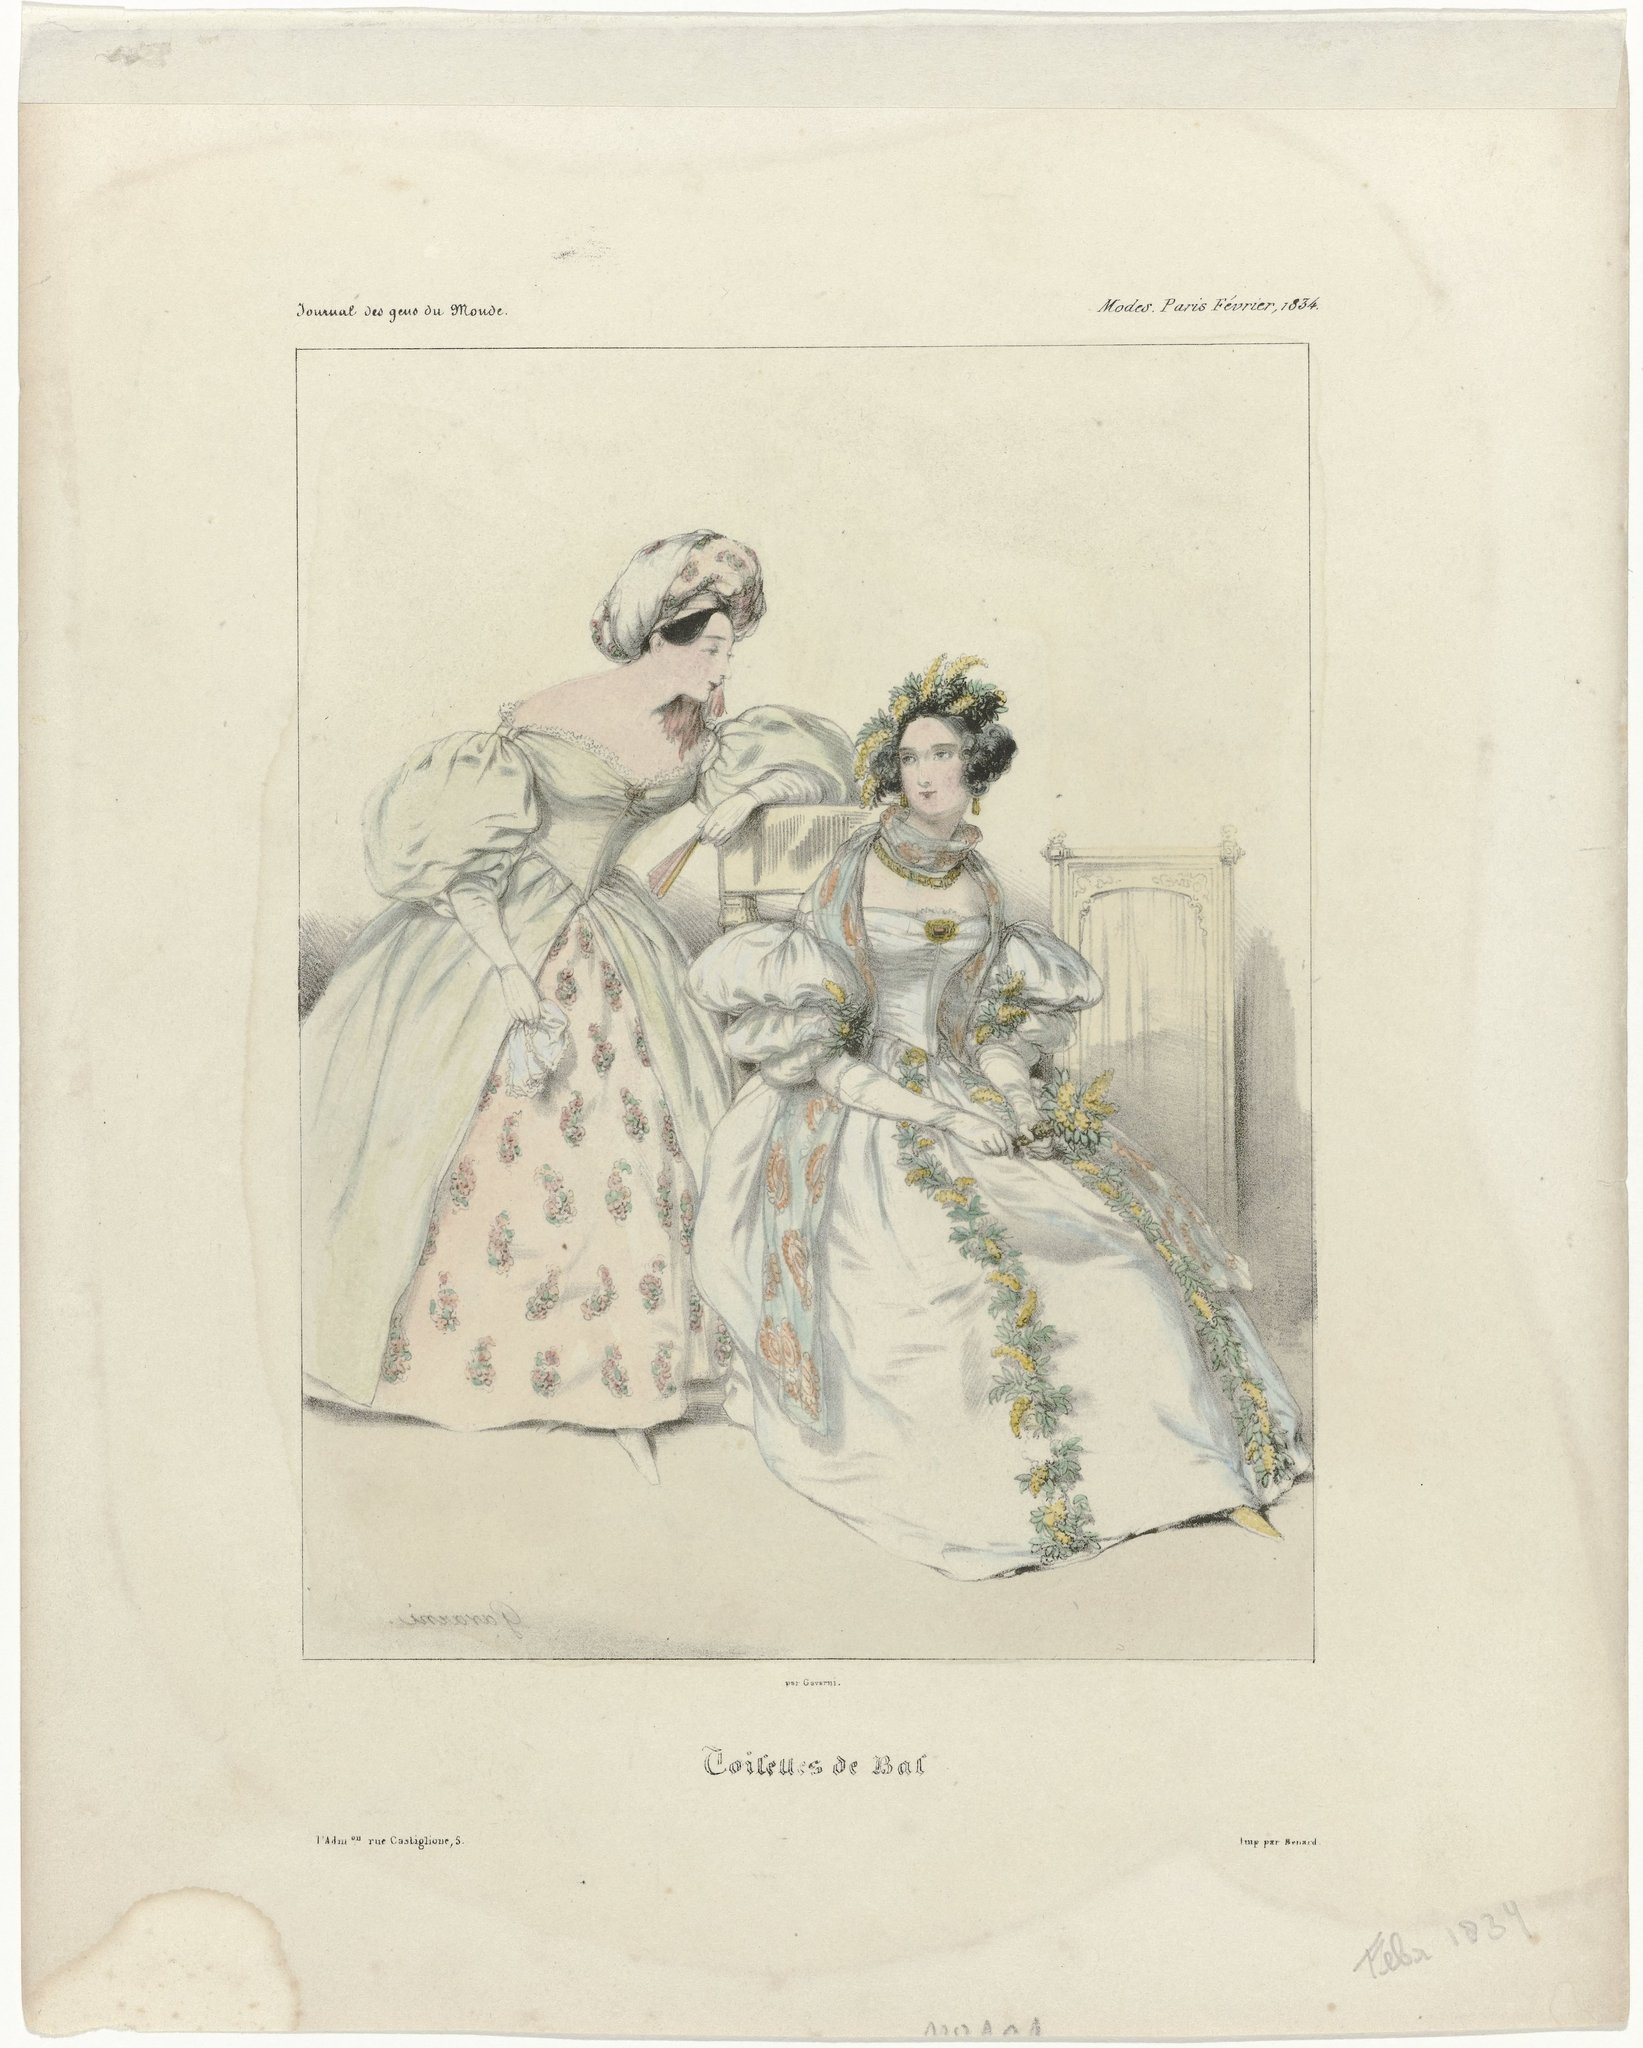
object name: fashion print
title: Journal des Gens du Monde, Modes Paris, février 1834 : Toilettes de Bal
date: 1834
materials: paper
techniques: hand coloring, lithograph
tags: ear-rings (+ women's clothes), handkerchief (+ women's clothes), brooch, agraffe, clasp (+ women's clothes), head-gear: turban (+ women's clothes), gloves, mittens (long gloves) (+ women's clothes), dress, gown: ball gown (+ women's clothes), fashion plates, fan (+ women's clothes), necklace (+ women's clothes)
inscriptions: address: ‘l'Adm.on rue Castiglione, 5.’, caption: ‘Toilettes de Bal’, title: ‘Journal des gens du Monde. / Modes. Paris Février, 1834.’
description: 'Toilettes de Bal'. Links: baljapon met puntig lijfje en onderrok met bloempatroon. Accessoires: tulband, handschoenen, waaier, zakdoek. Rechts: baljapon met geplooide mouwen en versierd met guirlandes. Accessoires:oorbellen, sjaal, collier, broche, lange handschoenen. Prent uit het modetijdschrift Journal des Gens du Monde (6 december 1833- mei 1834).